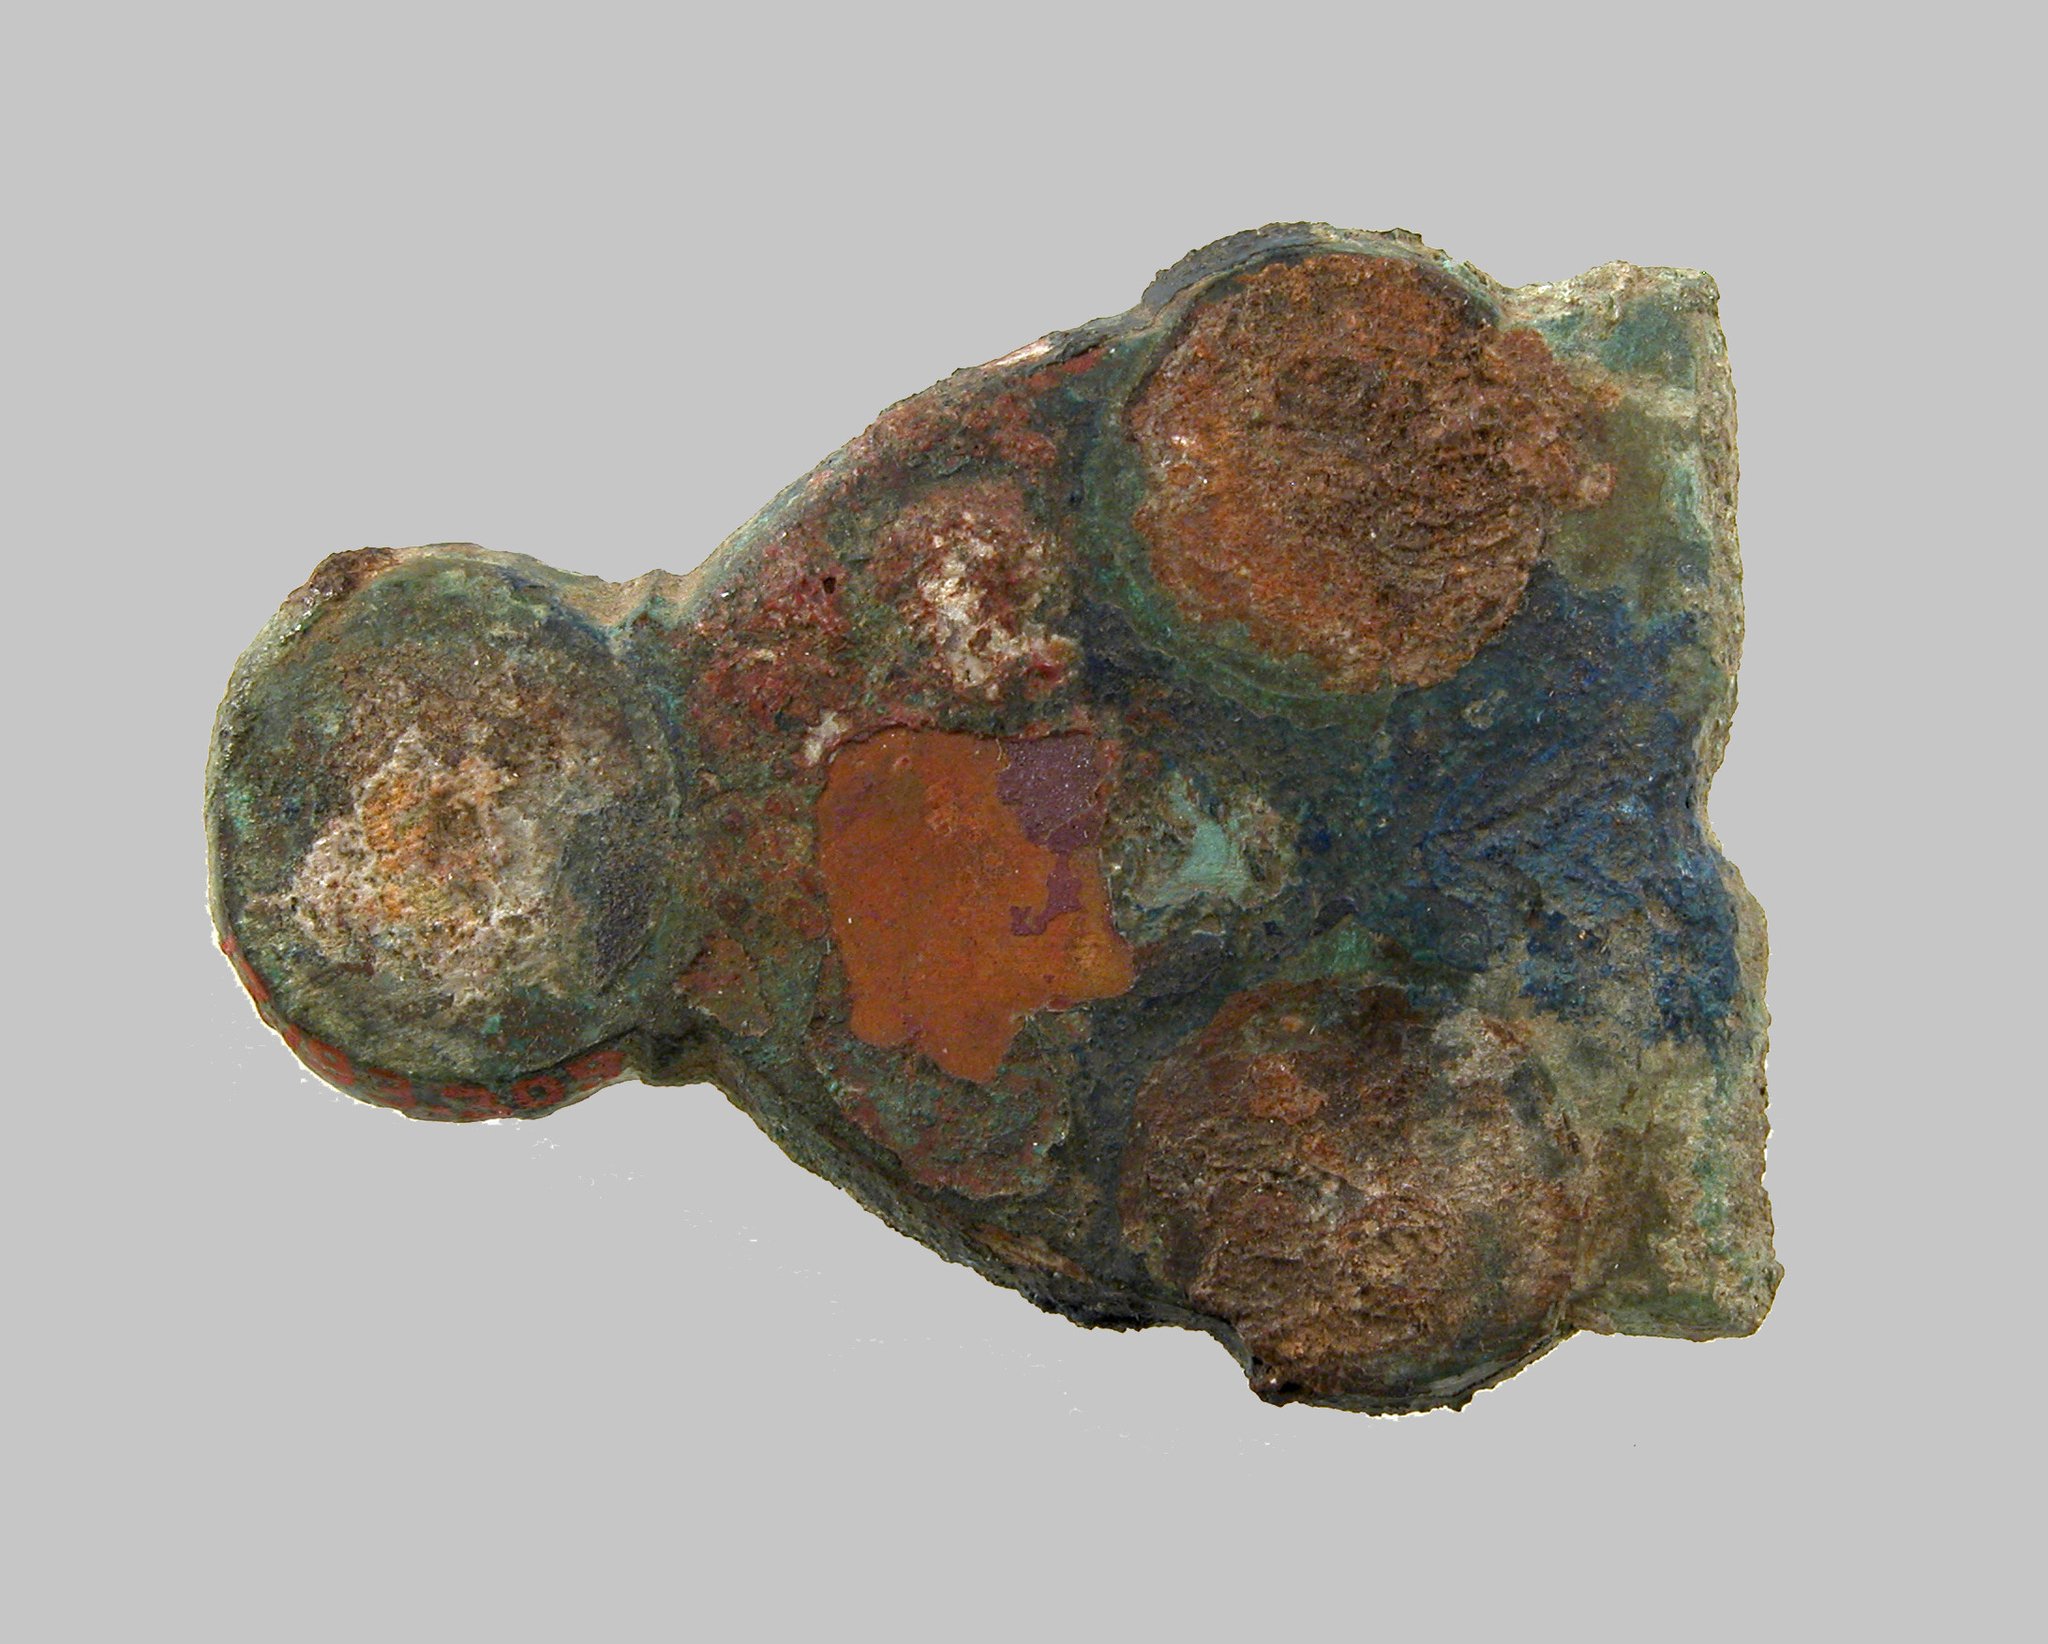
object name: plaque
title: Triangular Plaque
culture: frankish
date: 500-700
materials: copper alloy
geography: germany